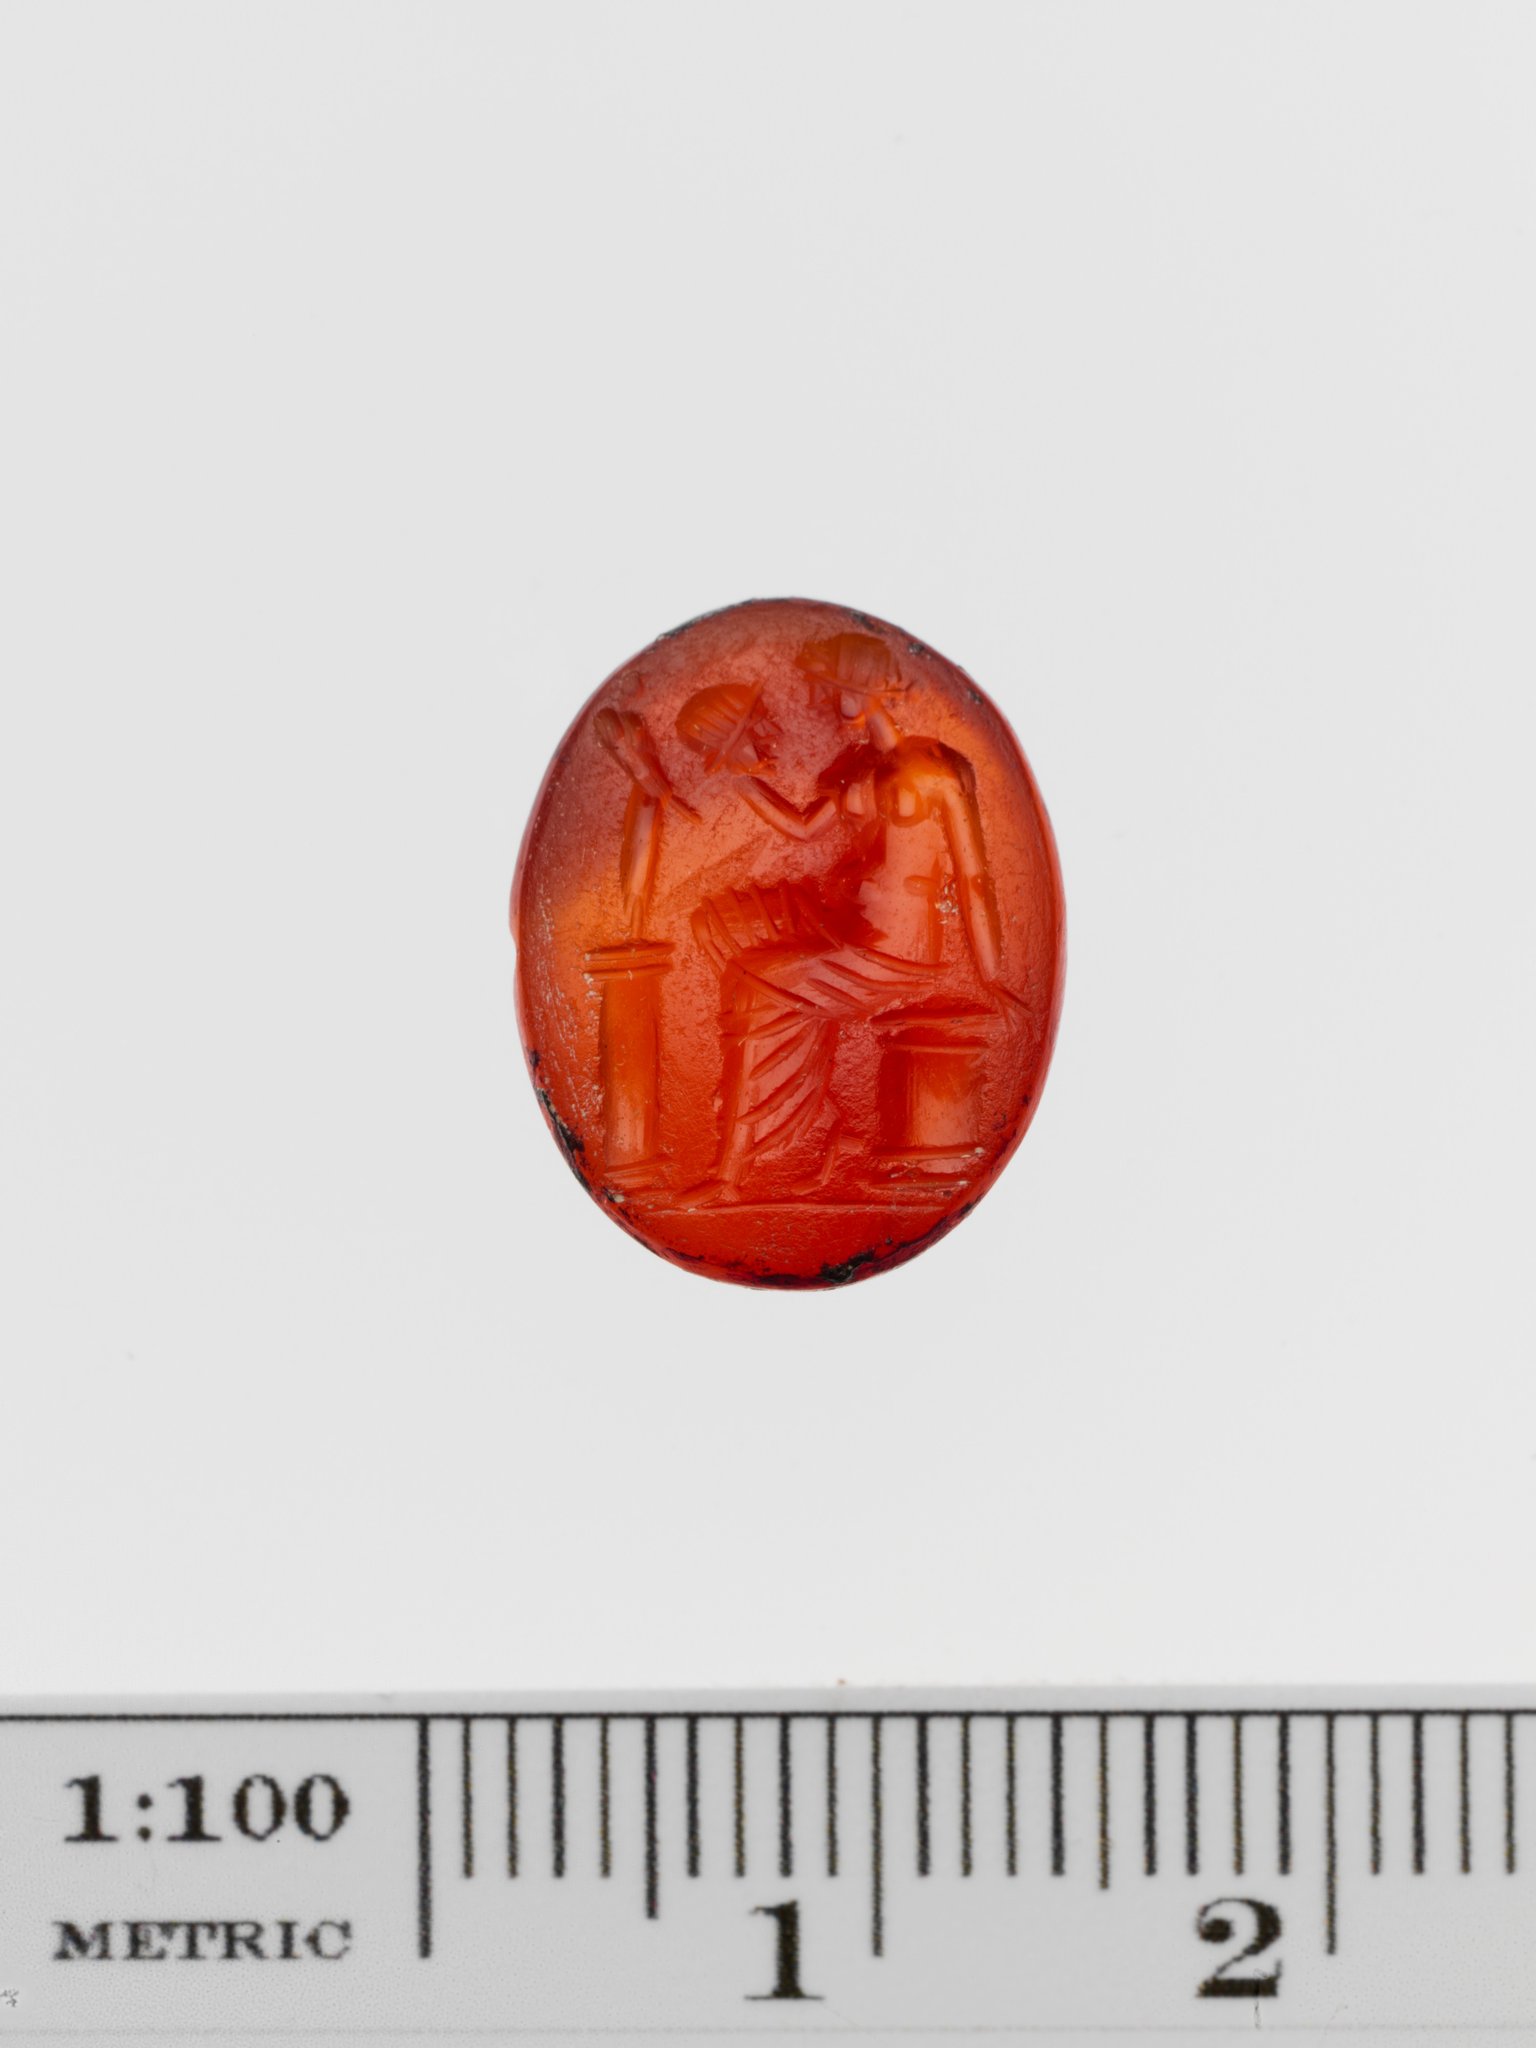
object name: intaglio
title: Carnelian ring stone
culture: roman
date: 100 BCE-300 CE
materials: gemstone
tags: masks,women